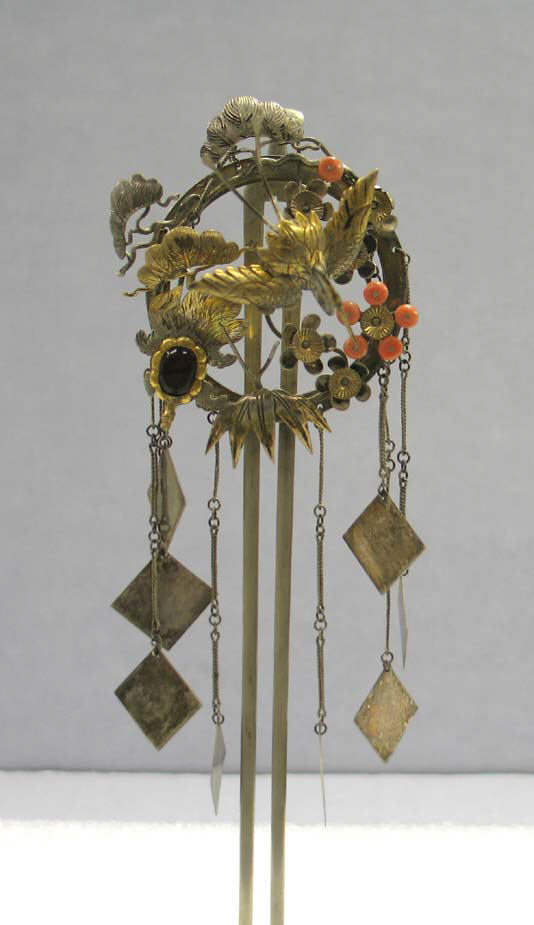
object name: hair ornament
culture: japanese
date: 1801-1900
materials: silver, silver gilt